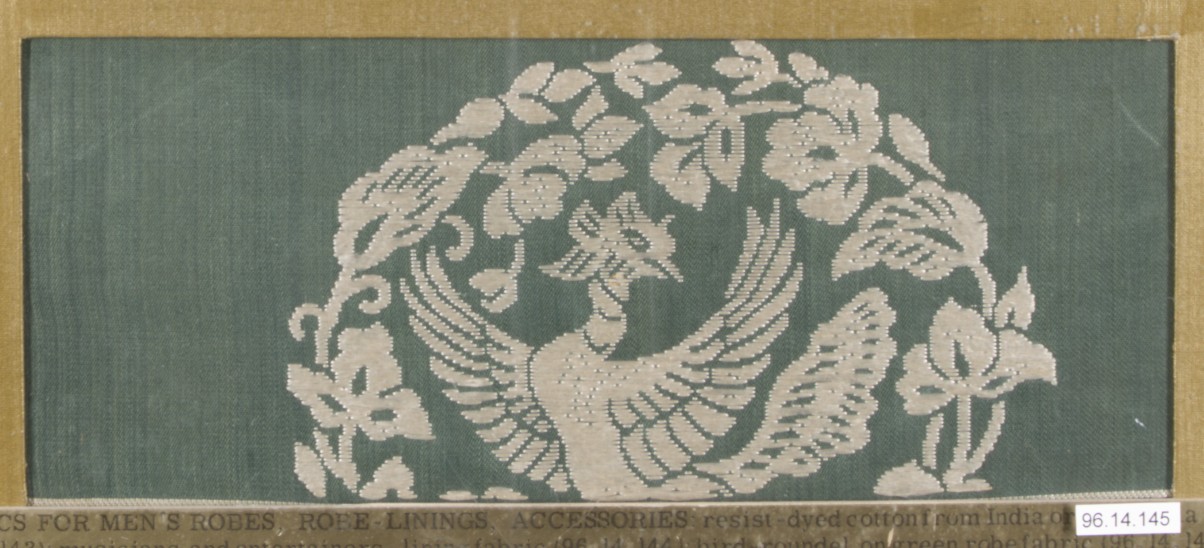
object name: piece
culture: japanese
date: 1801-1900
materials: silk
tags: birds